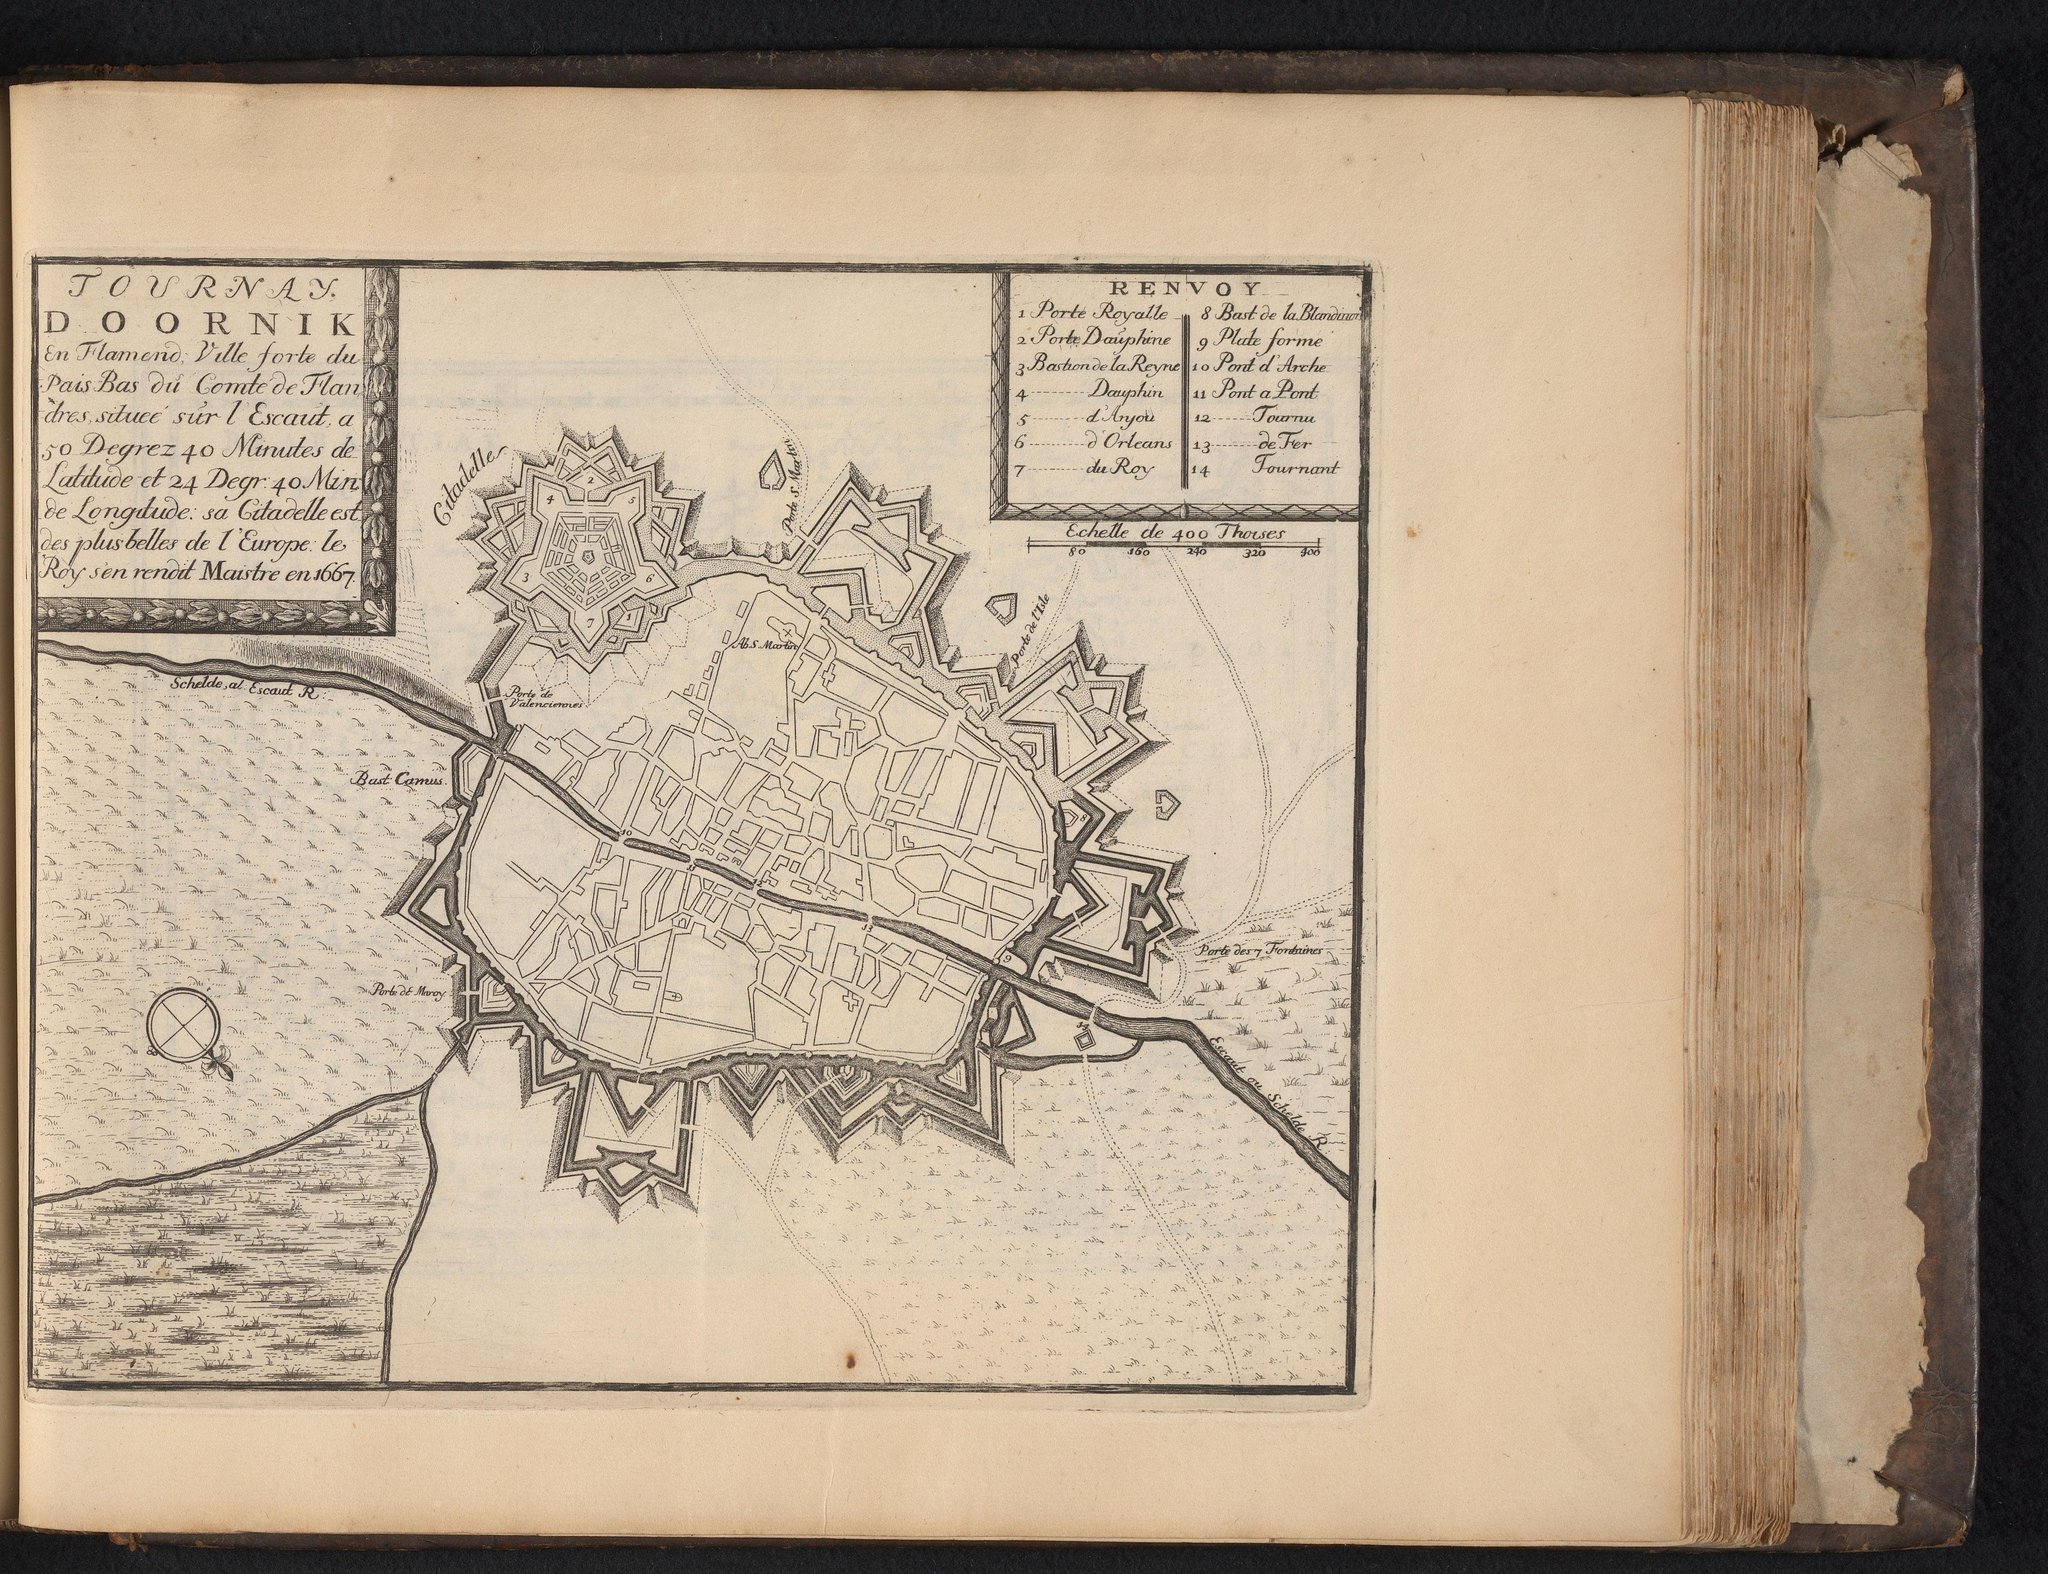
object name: map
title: Plattegrond van Tournai, ca. 1693-1696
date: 1693-1696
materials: paper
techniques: etching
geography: paris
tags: fortress, maps of cities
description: Plattegrond van de versterkingen om de Vlaamse stad Tournai (Doornik). Onderdeel van het eerste van twee delen van het prentwerk: Le Theatre de la Guerre, dans les Pays-Bas, waarvan het titelblad uitgegeven is in 1696. Het prentwerk bestaat in totaal (beide delen) uit 52 platen met plannen (afkomstig van Sébastien Le Prestre, Seigneur de Vauban) van vermaarde sterke steden en vestingen in de Negenjarige Oorlog in de Nederlanden. Variant (kopie?) van de plaat die voorkomt in: Les forces de l'Europe, uitgegeven tussen 1693-1697. Titel en opschriften in het Frans.